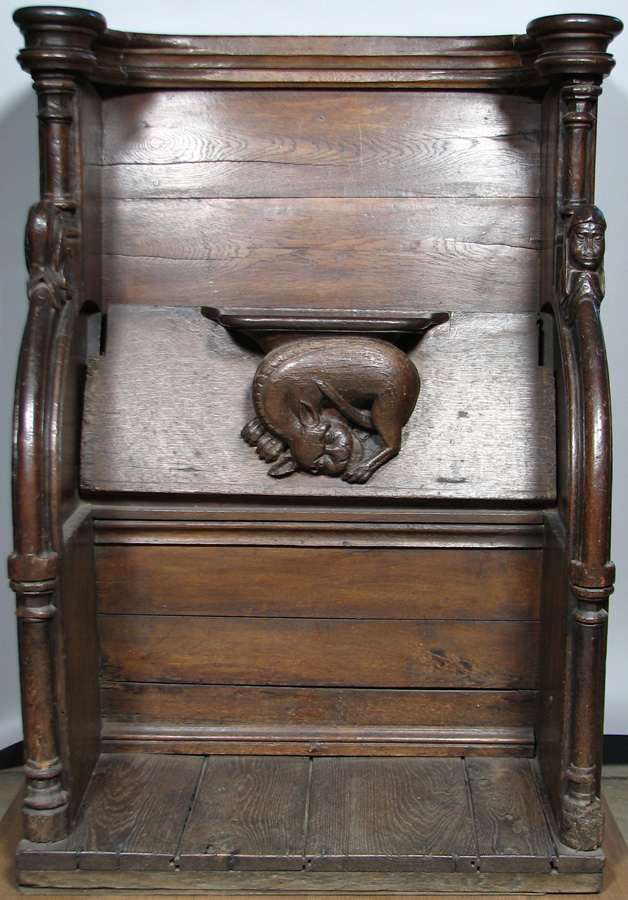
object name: choir stall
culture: french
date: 1401-1500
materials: wood